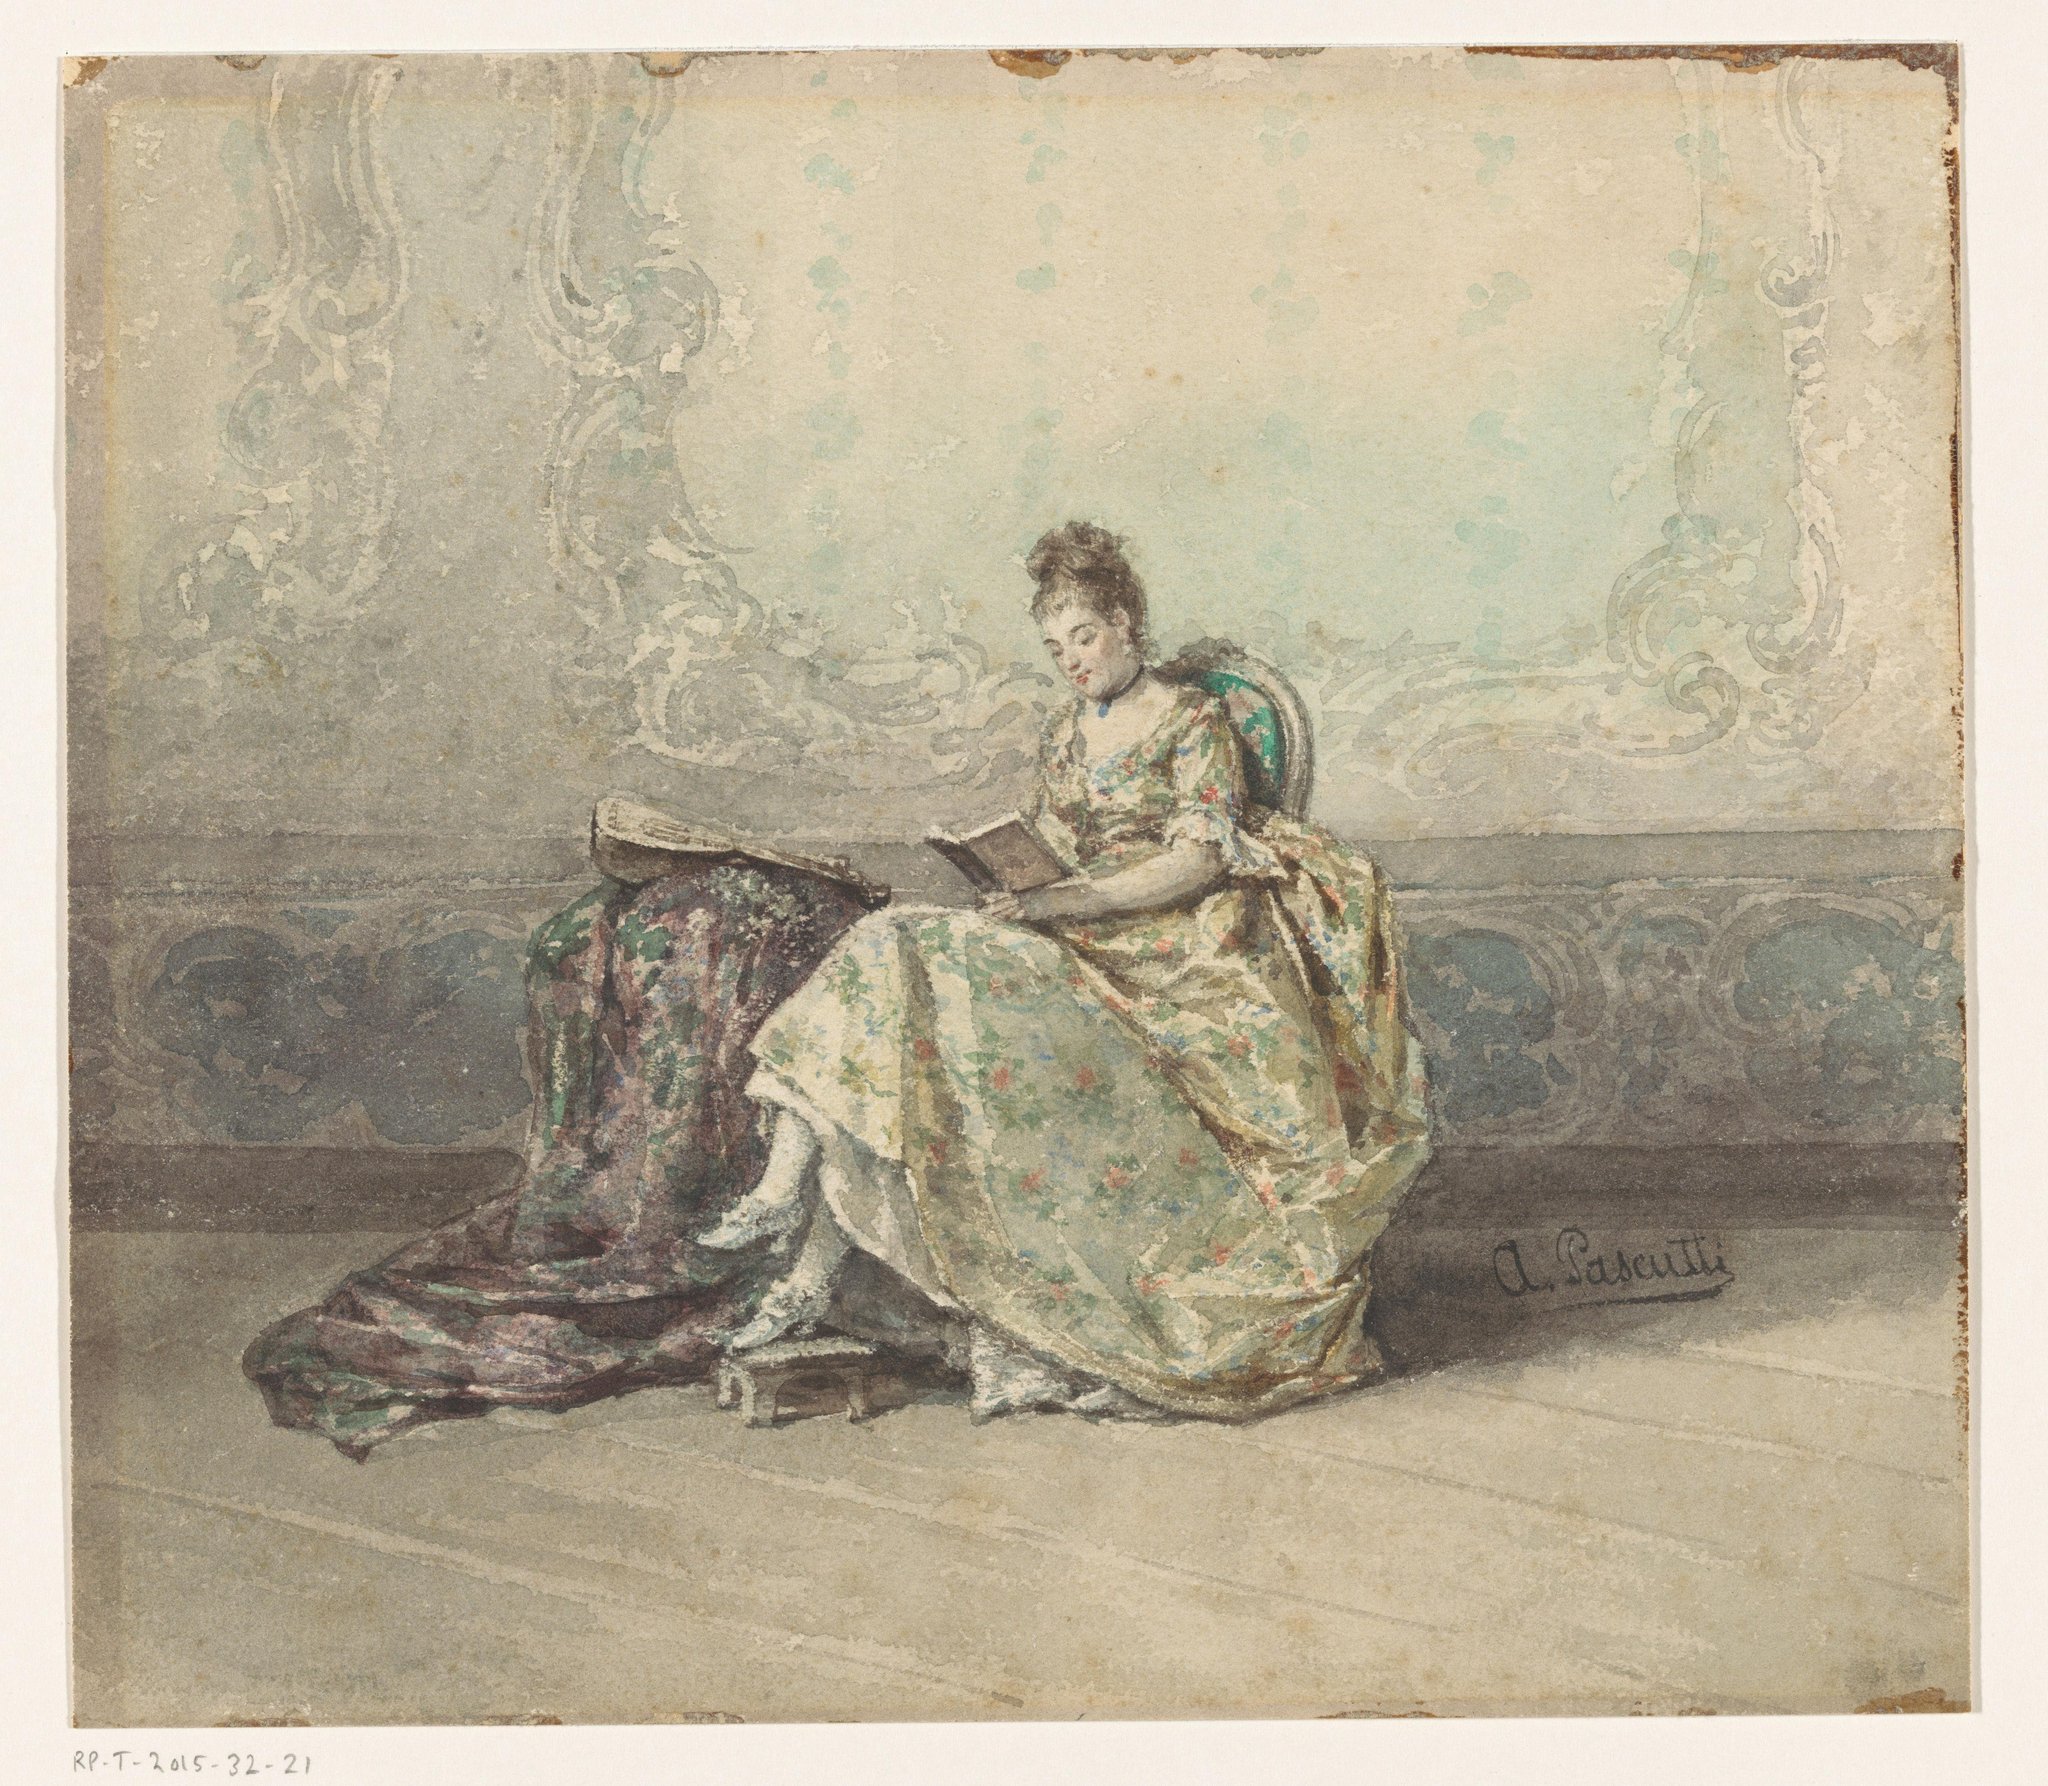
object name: drawing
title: Lezende jonge vrouw in een stoel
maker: antonio pascutti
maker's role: draughtsman, painter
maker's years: 1832-1892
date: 1842-1892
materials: paper, watercolor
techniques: brush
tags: lute, and special forms of lute, e.g.: theorbo, newspaper, news-sheet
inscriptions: collector's mark: Lugt 4780, collector's mark: Lugt 4779, collector's mark: Lugt 2228, annotation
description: Naast haar een tafel met een kleed met daarop een luit.